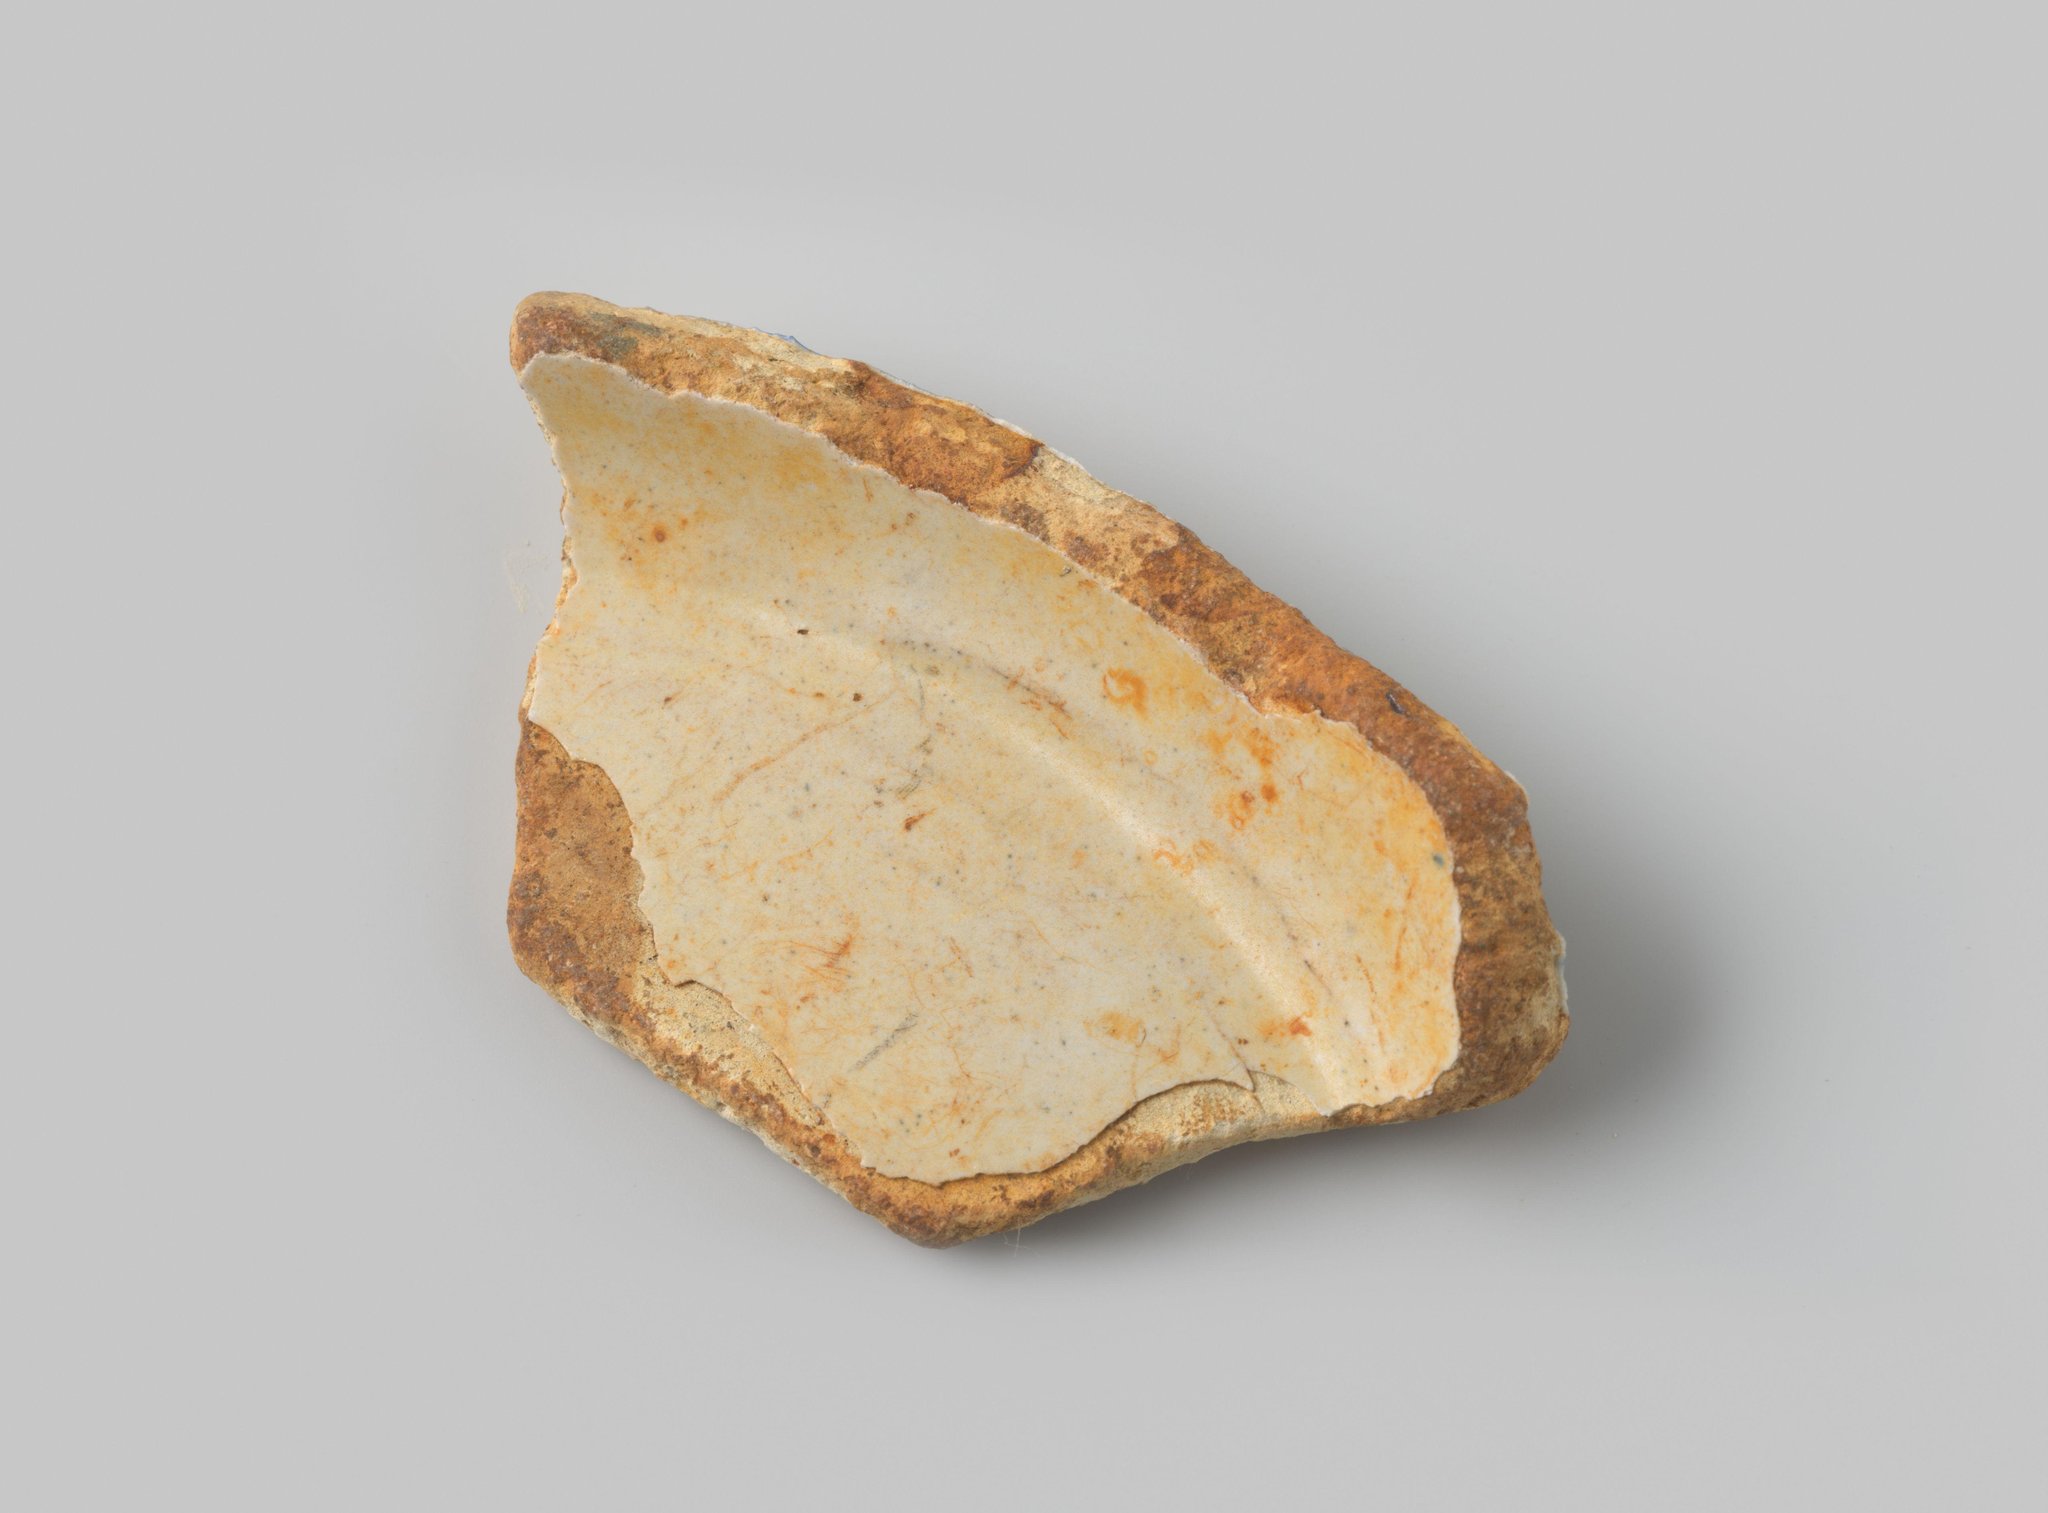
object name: apothecary jar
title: Scherf van een apothekerspot uit het wrak van de Oost-Indiëvaarder Hollandia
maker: Anonymous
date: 1700-1743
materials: faience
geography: netherlands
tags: verenigde oostindische compagnie, hollandia (schip), annet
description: Faience (tin-glazed), apothecaries'jars; fragm of base, eroded, circular, flat, semicircular notch above base, set off with a blue band, totally glazed.